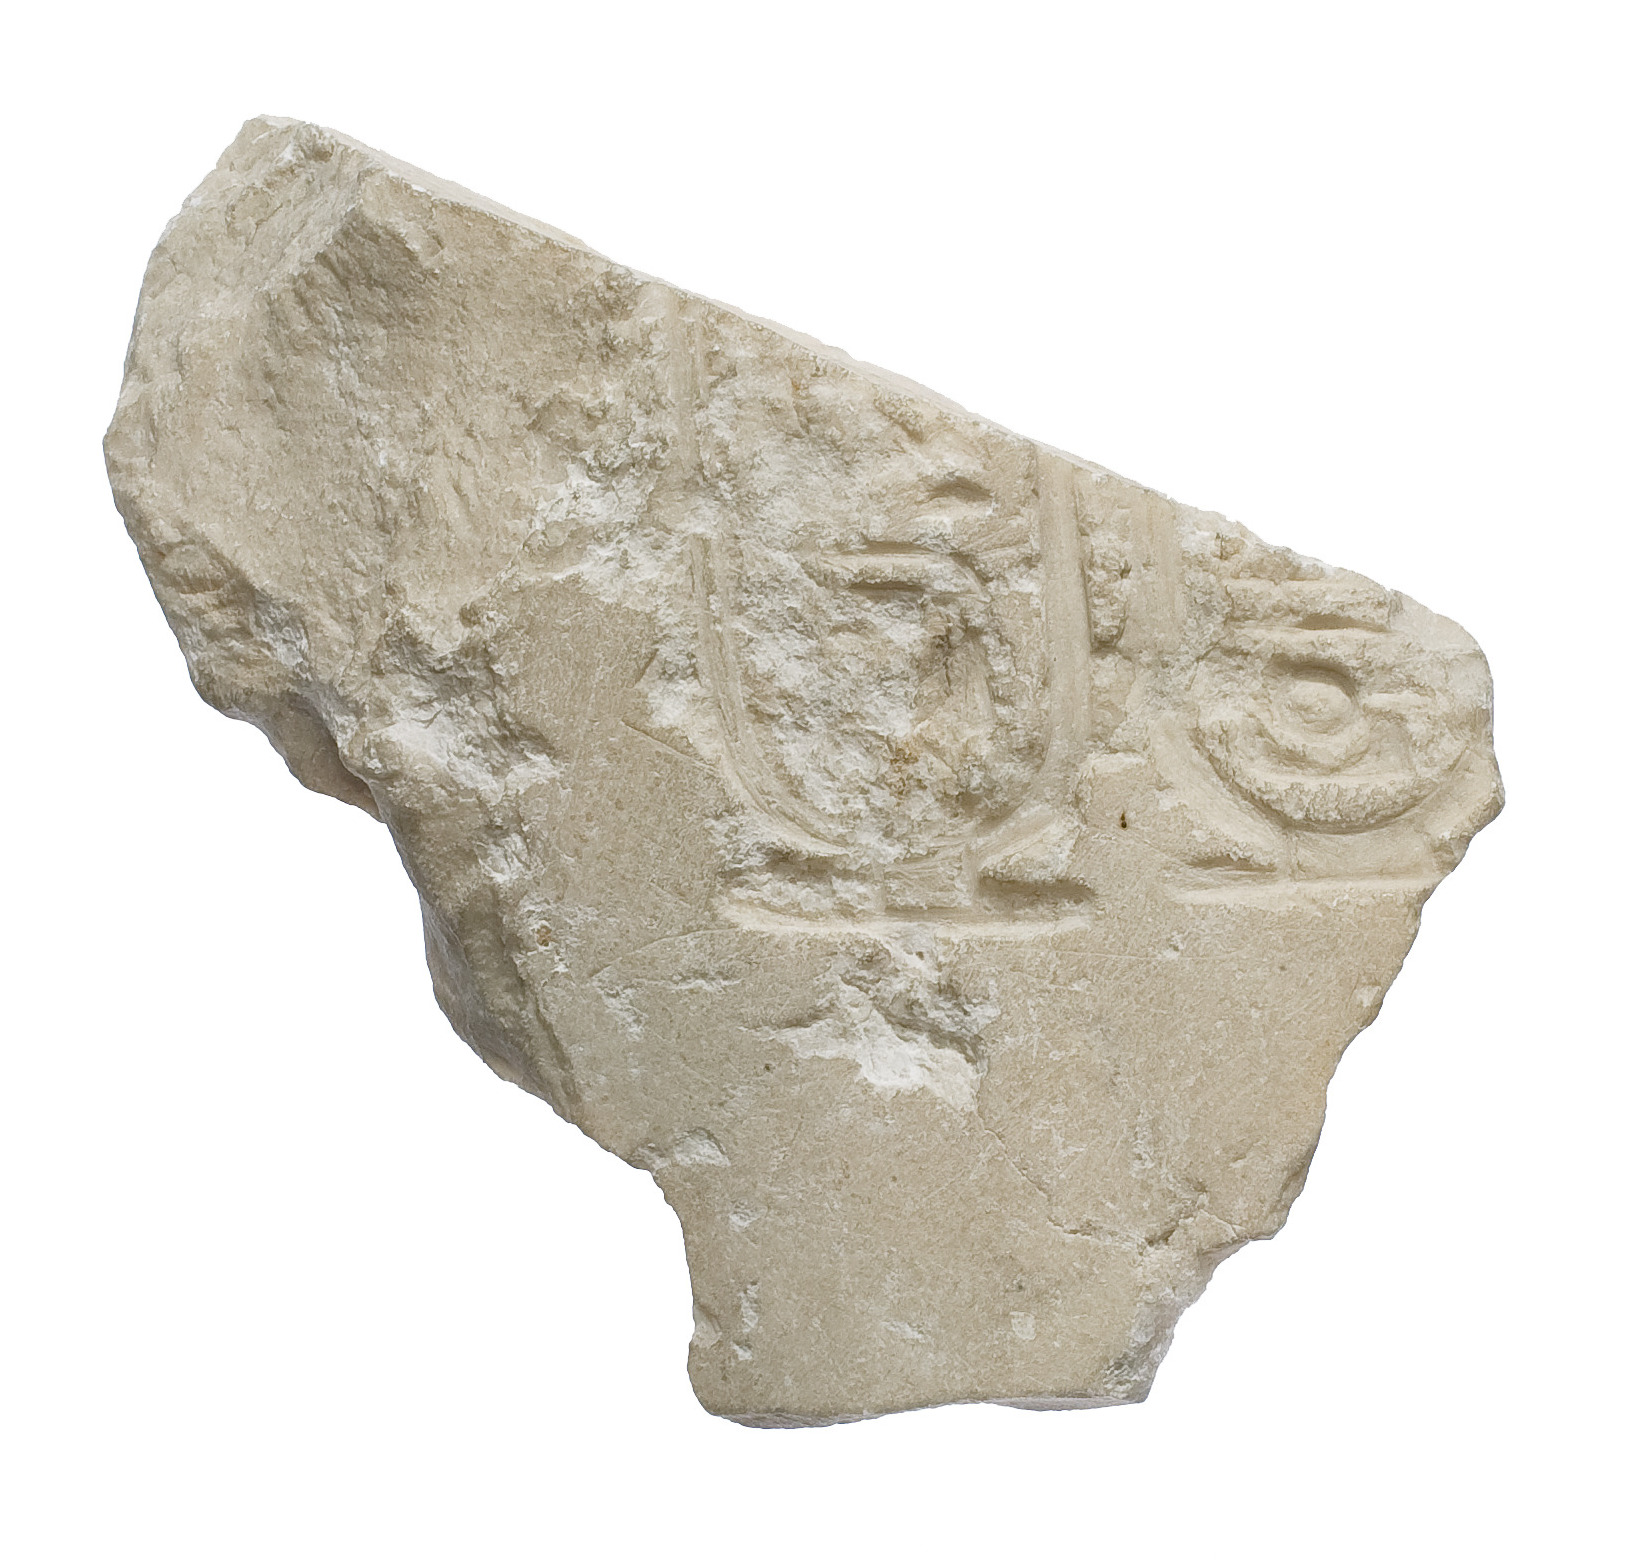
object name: akhenaten chest or abdomen, aten cartouch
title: Chest or abdomen of Akhenaten, Aten cartouches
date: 1352-1336 BCE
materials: limestone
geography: egypt